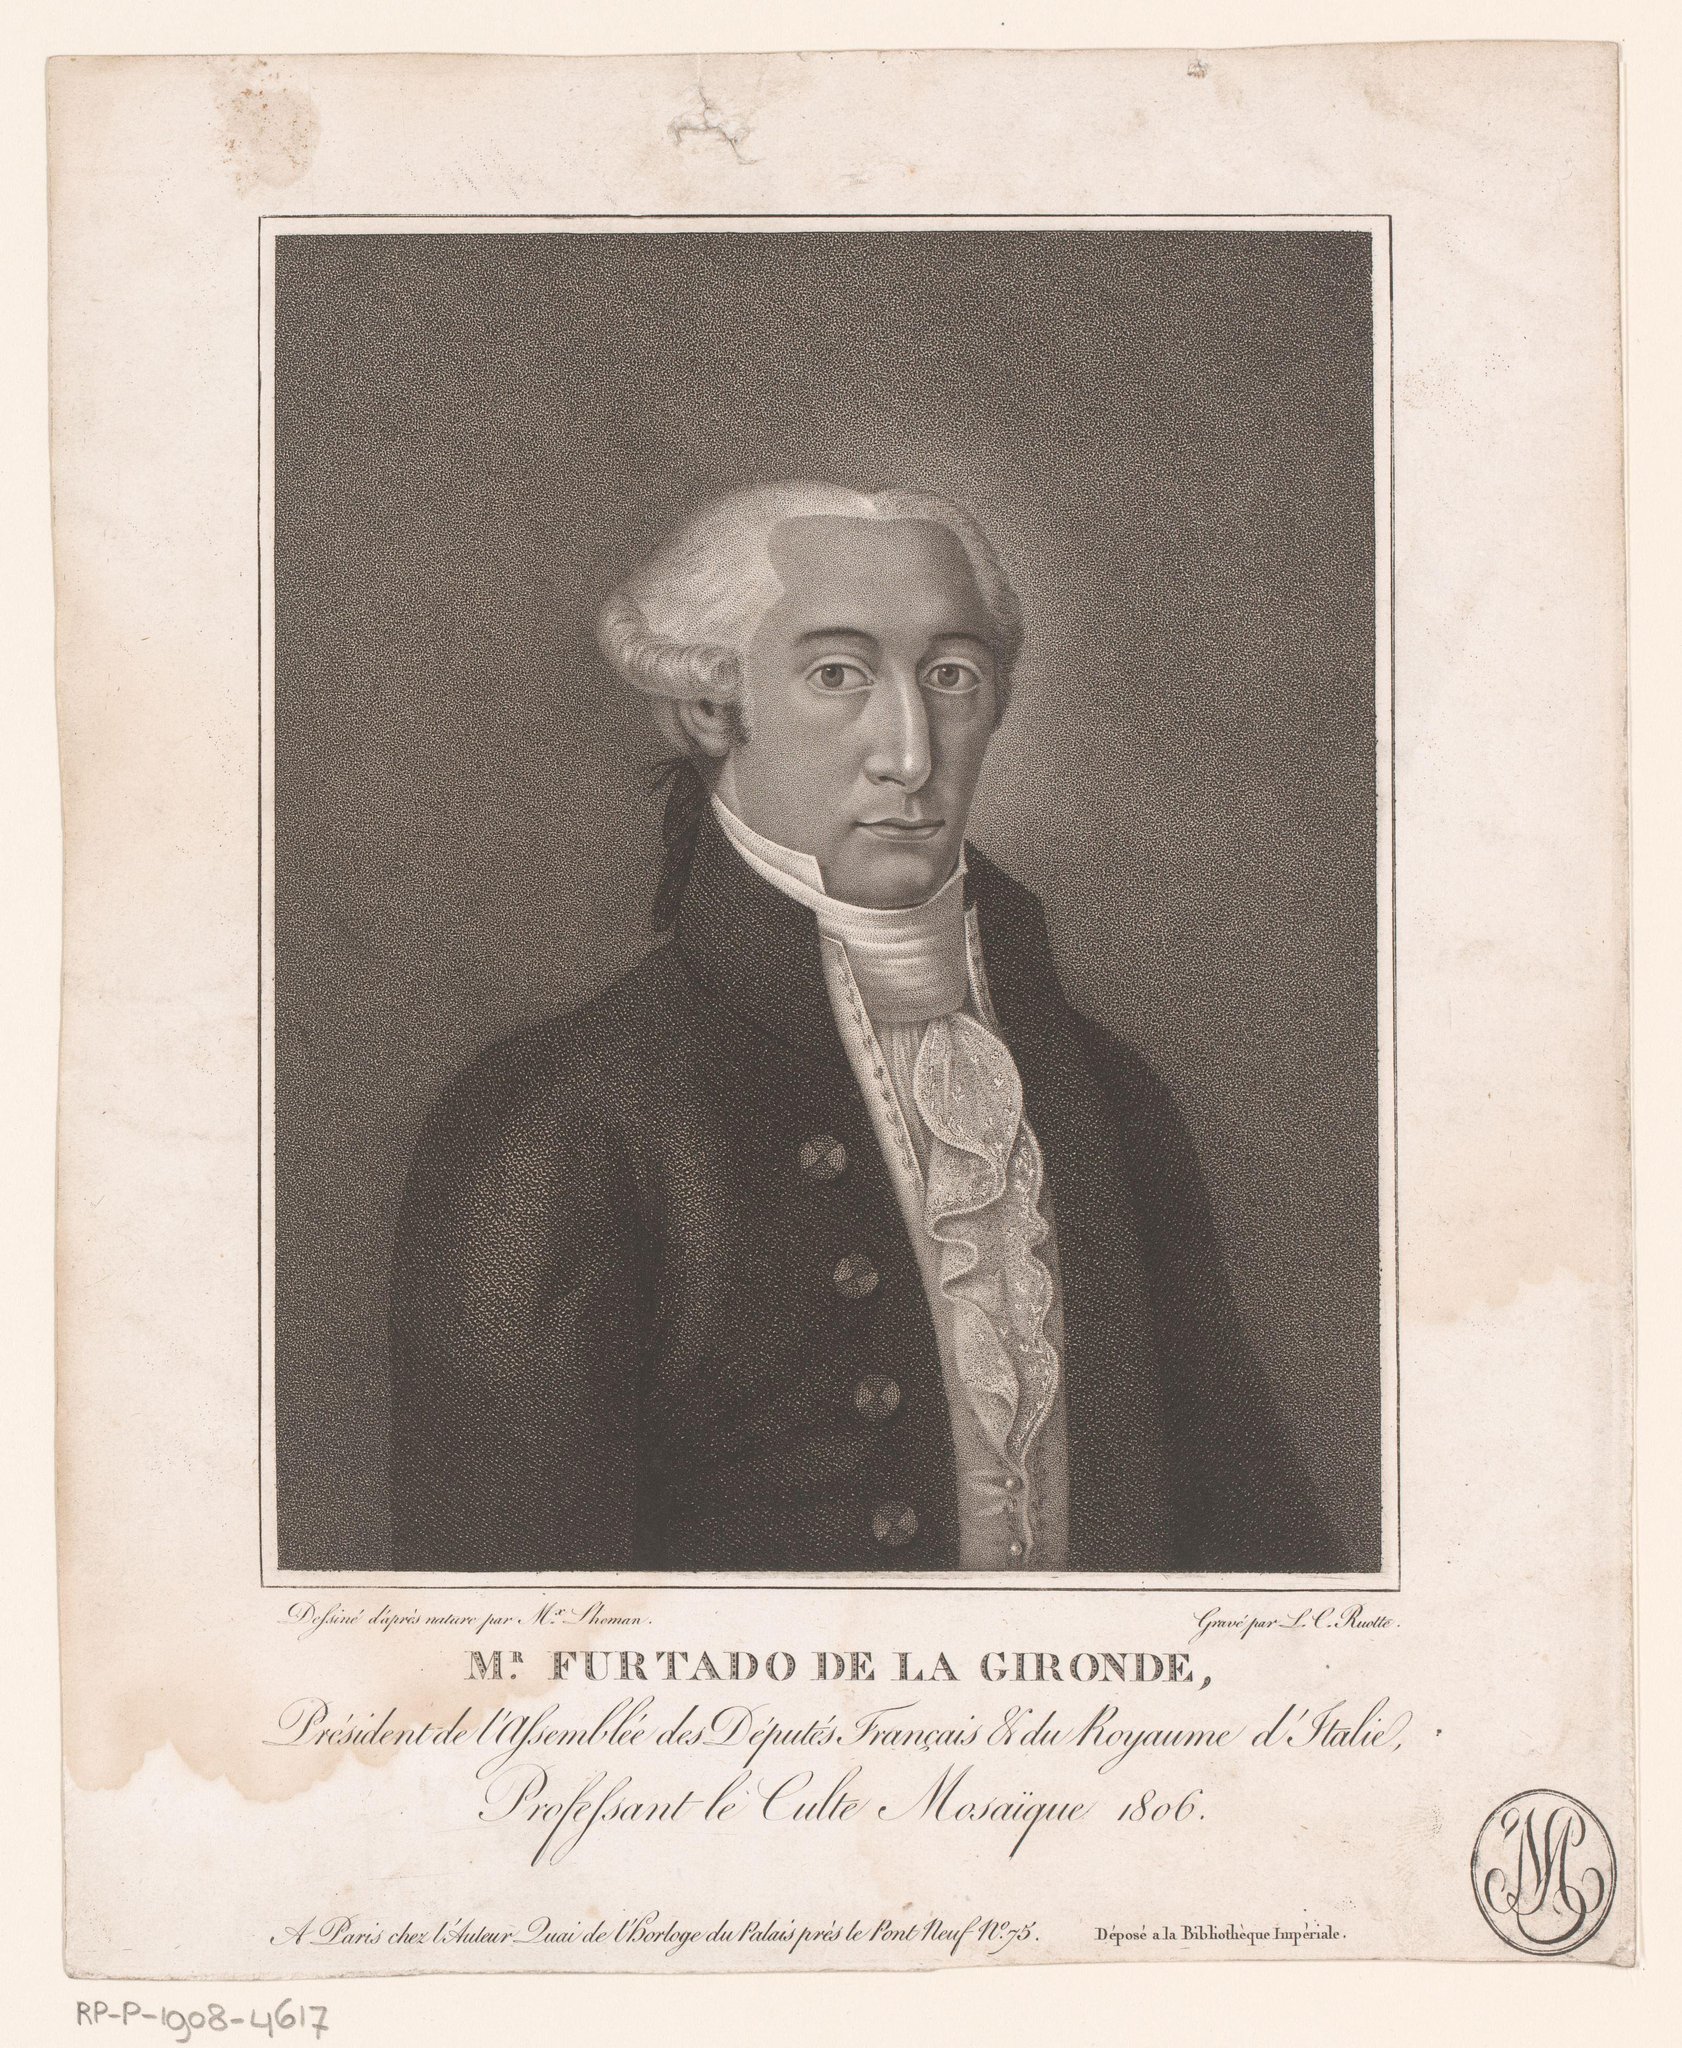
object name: print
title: Portret van Abraham Furtado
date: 1806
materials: paper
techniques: etching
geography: paris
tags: london, politician, minister ~ government, historical persons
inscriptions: collector's mark: Lugt 4086, : ‘Déposé à la Bibliothèque Impériale’, collector's mark: Lugt 2228